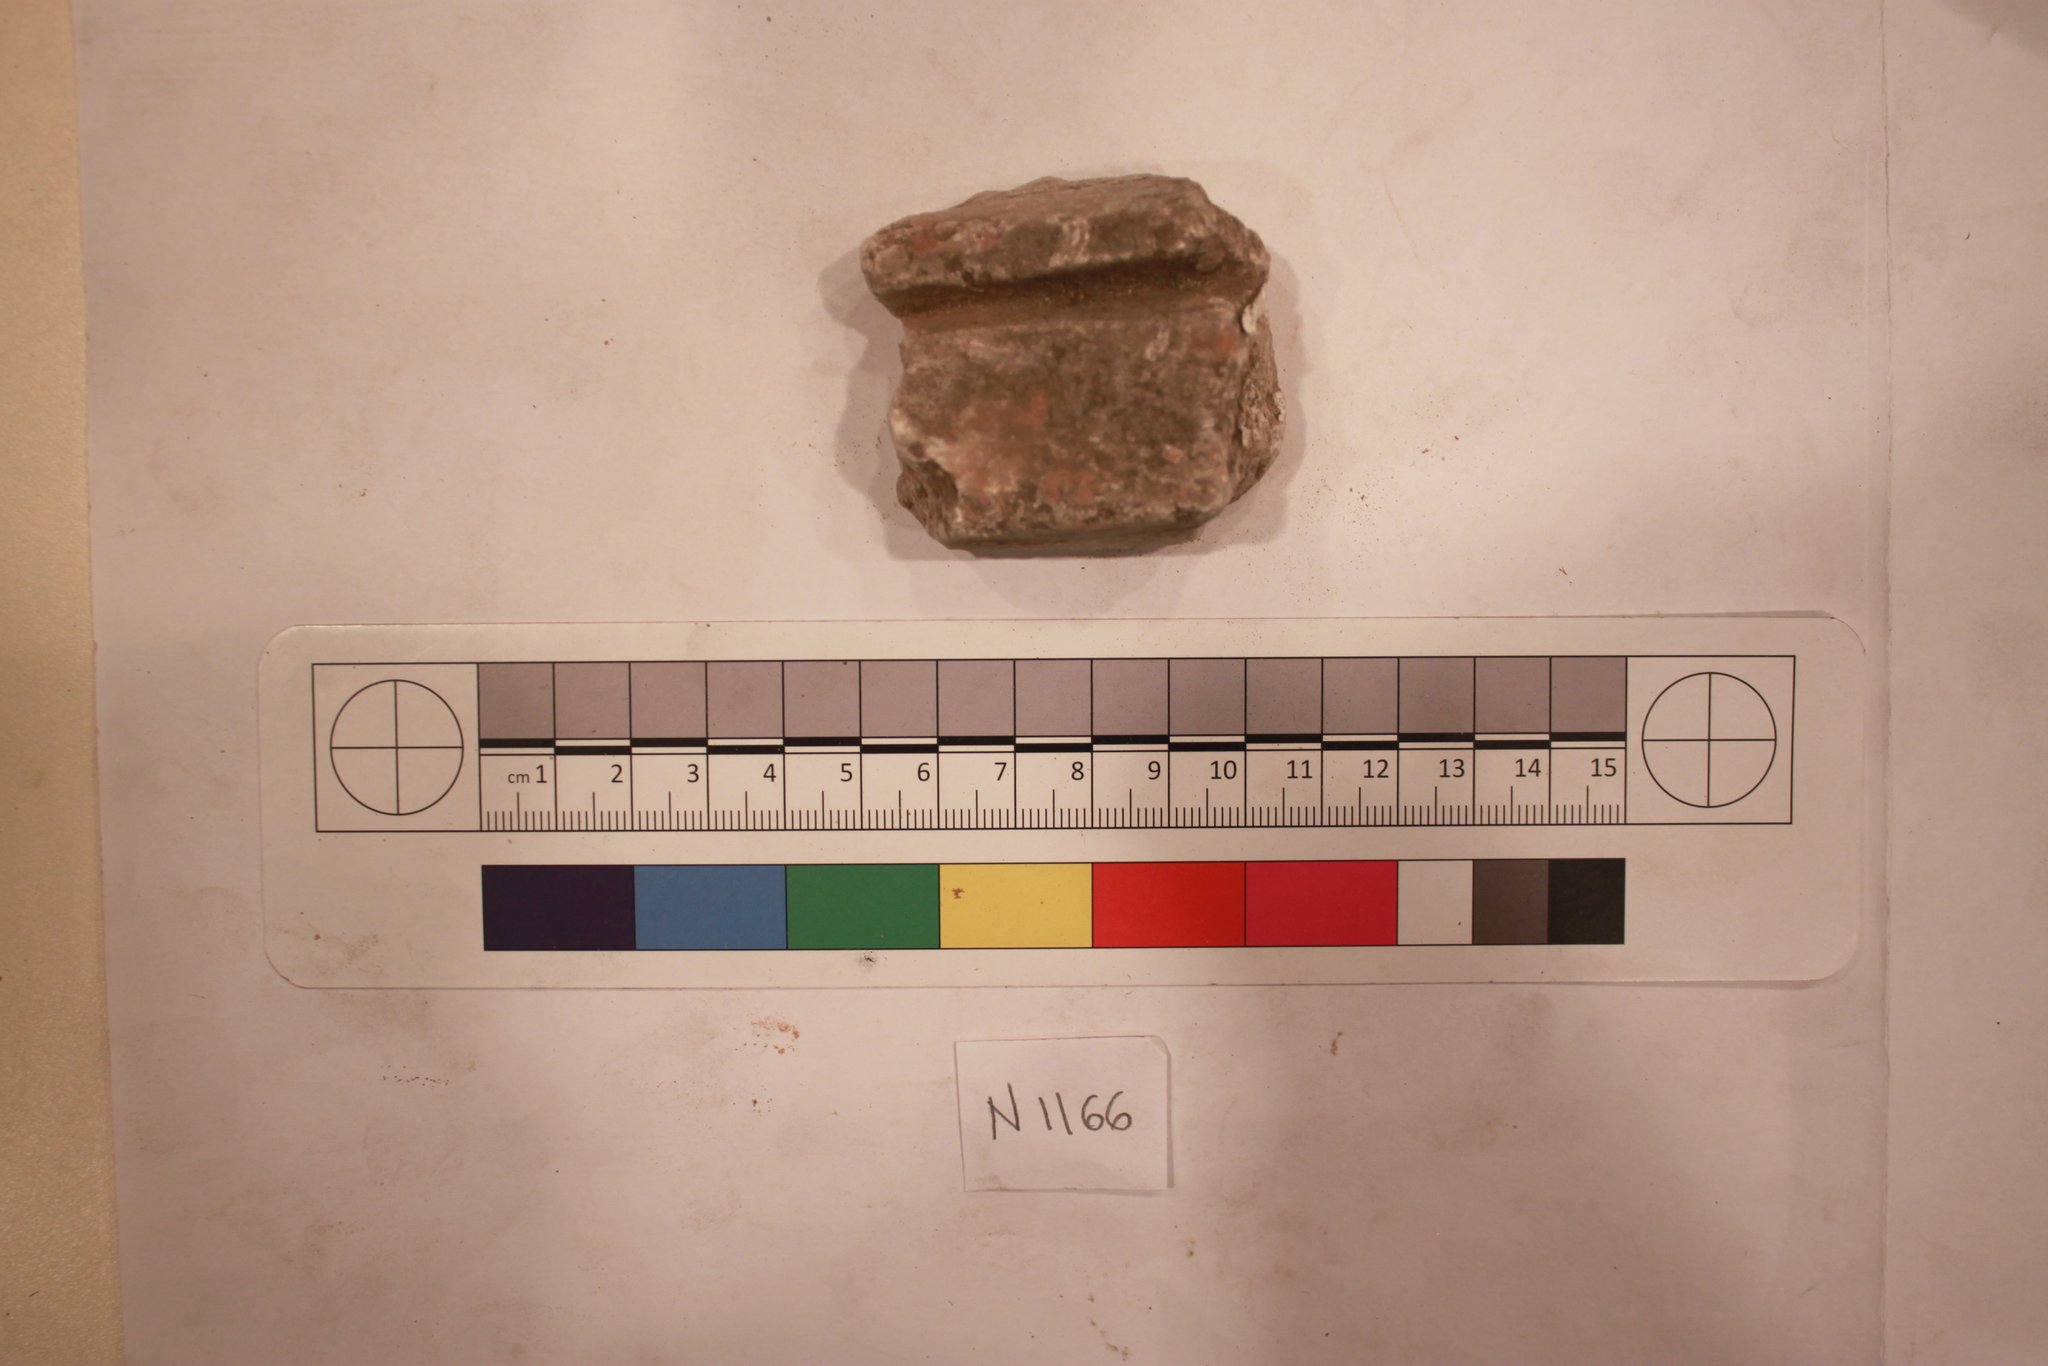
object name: fragment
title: Stucco Fragment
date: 701-1200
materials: plaster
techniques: carving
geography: iran